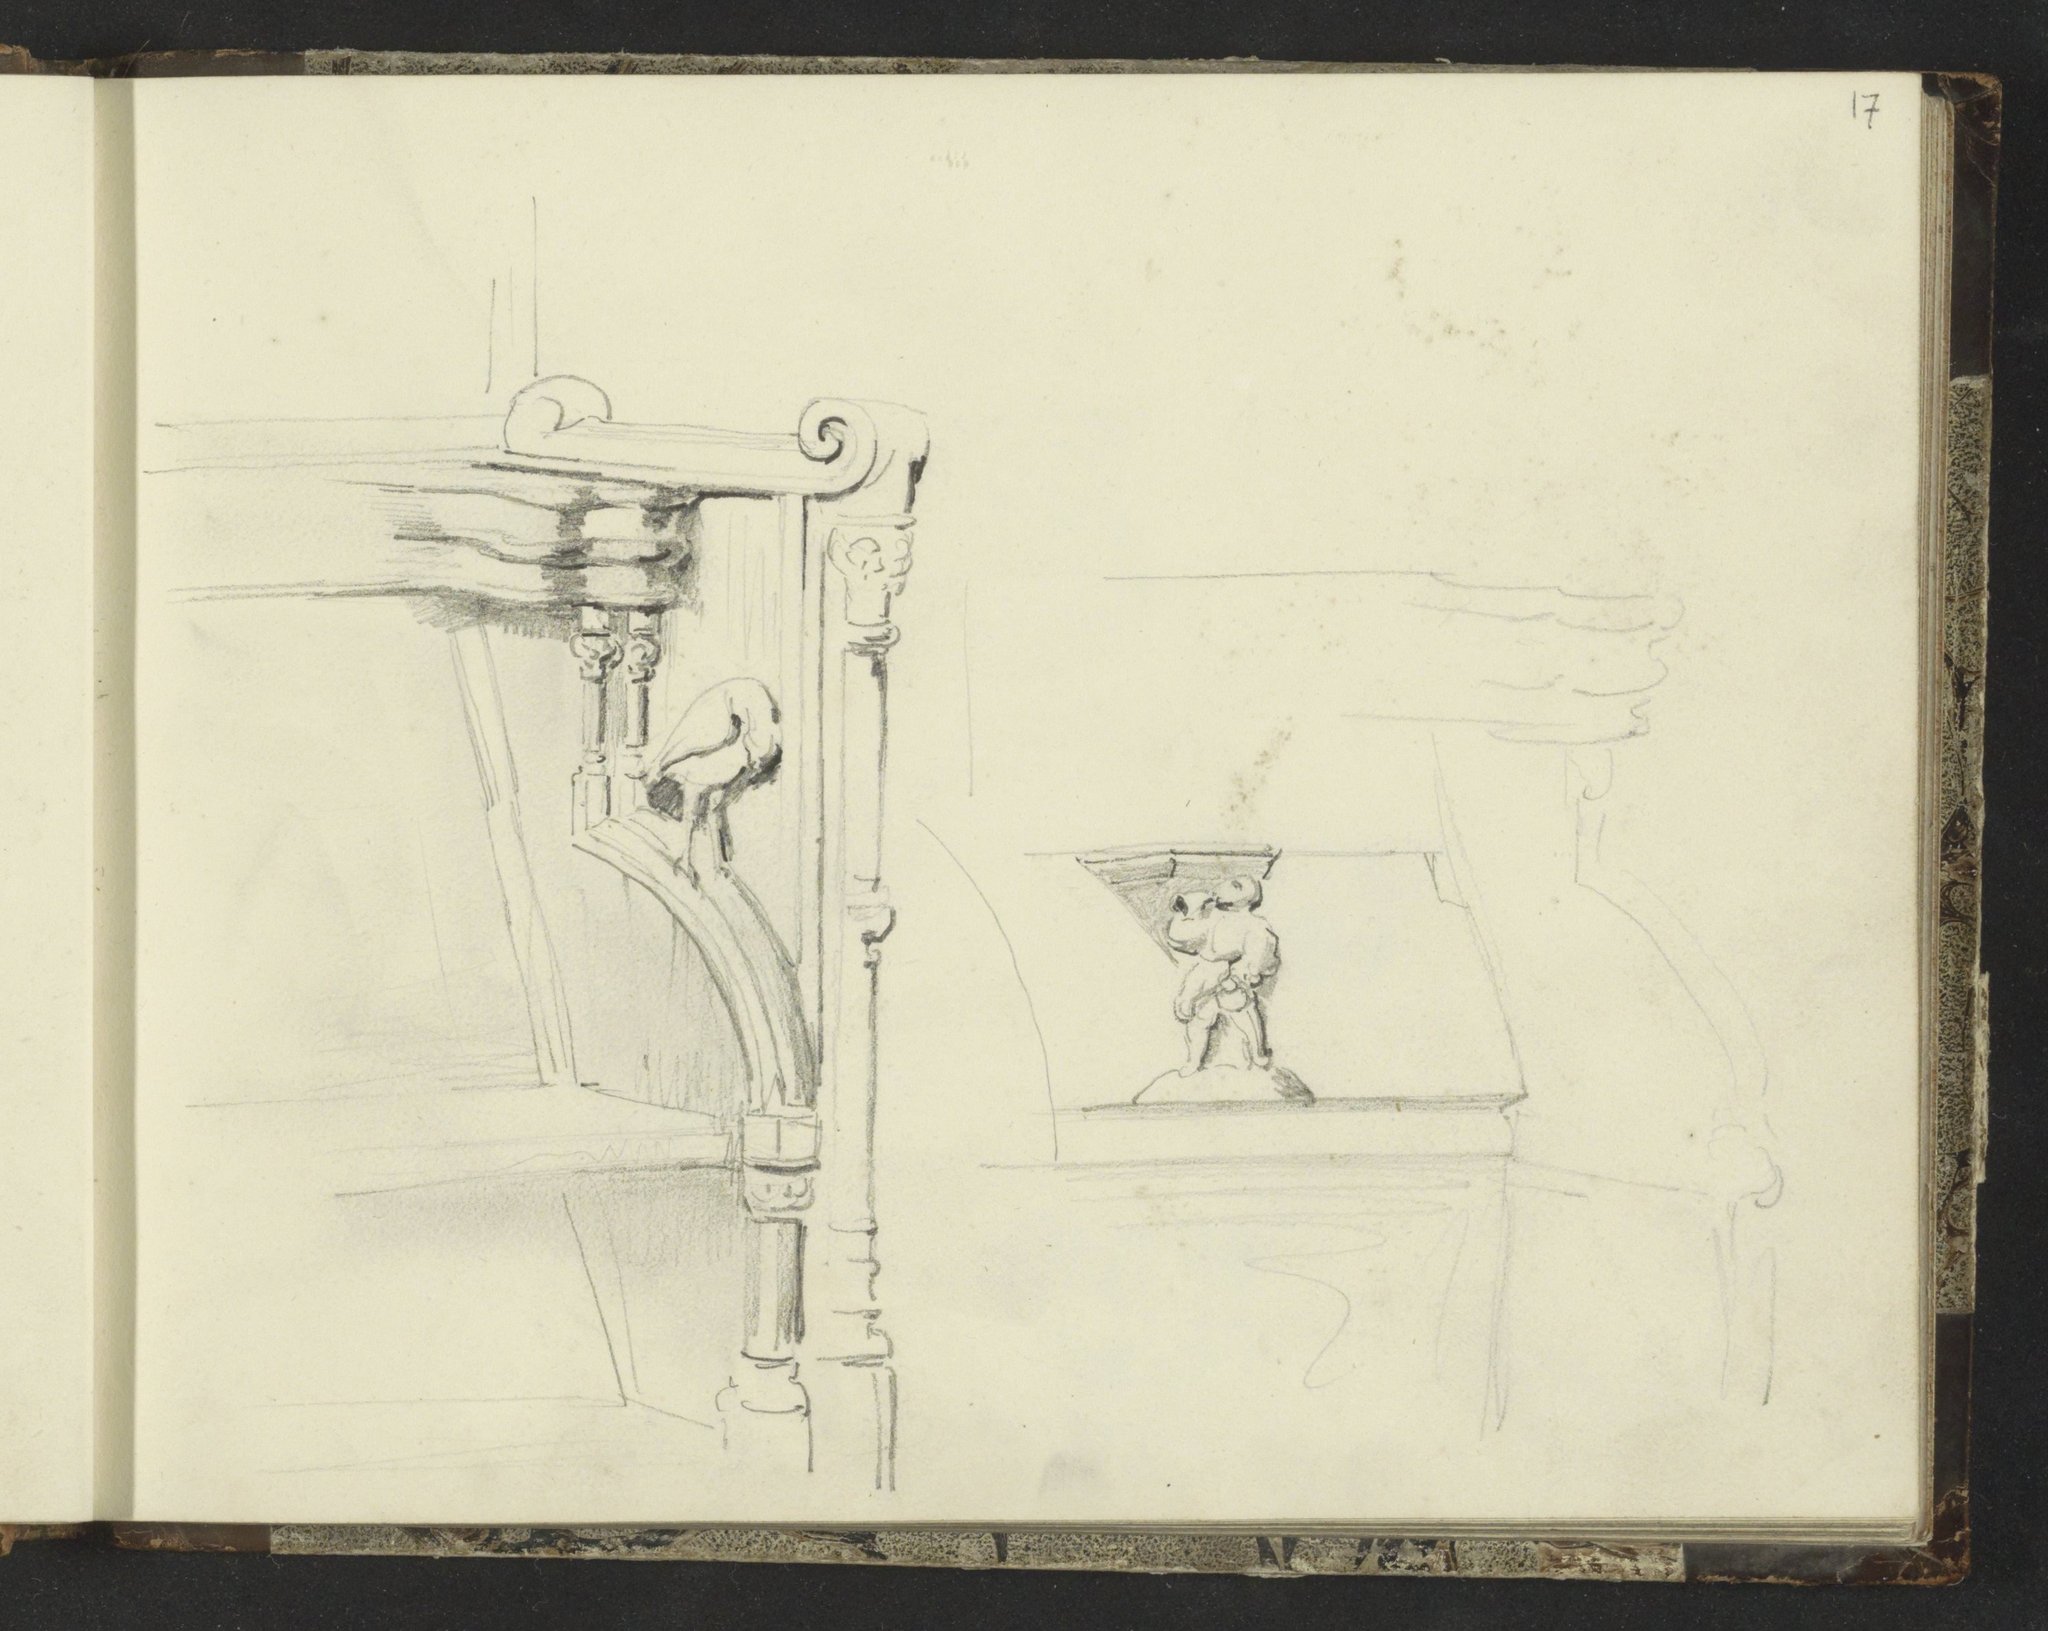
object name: sketchbook leaf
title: Wang van de koorbank van de Onze-Lieve-Vrouwekerk te Breda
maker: willem hendrik schmidt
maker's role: draughtsman, painter, print maker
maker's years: 1809-1849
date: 1819-1849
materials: paper, pencil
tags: seats of the clergy, choir-stalls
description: Blad 17 recto uit een schetsboek met 58 bladen.